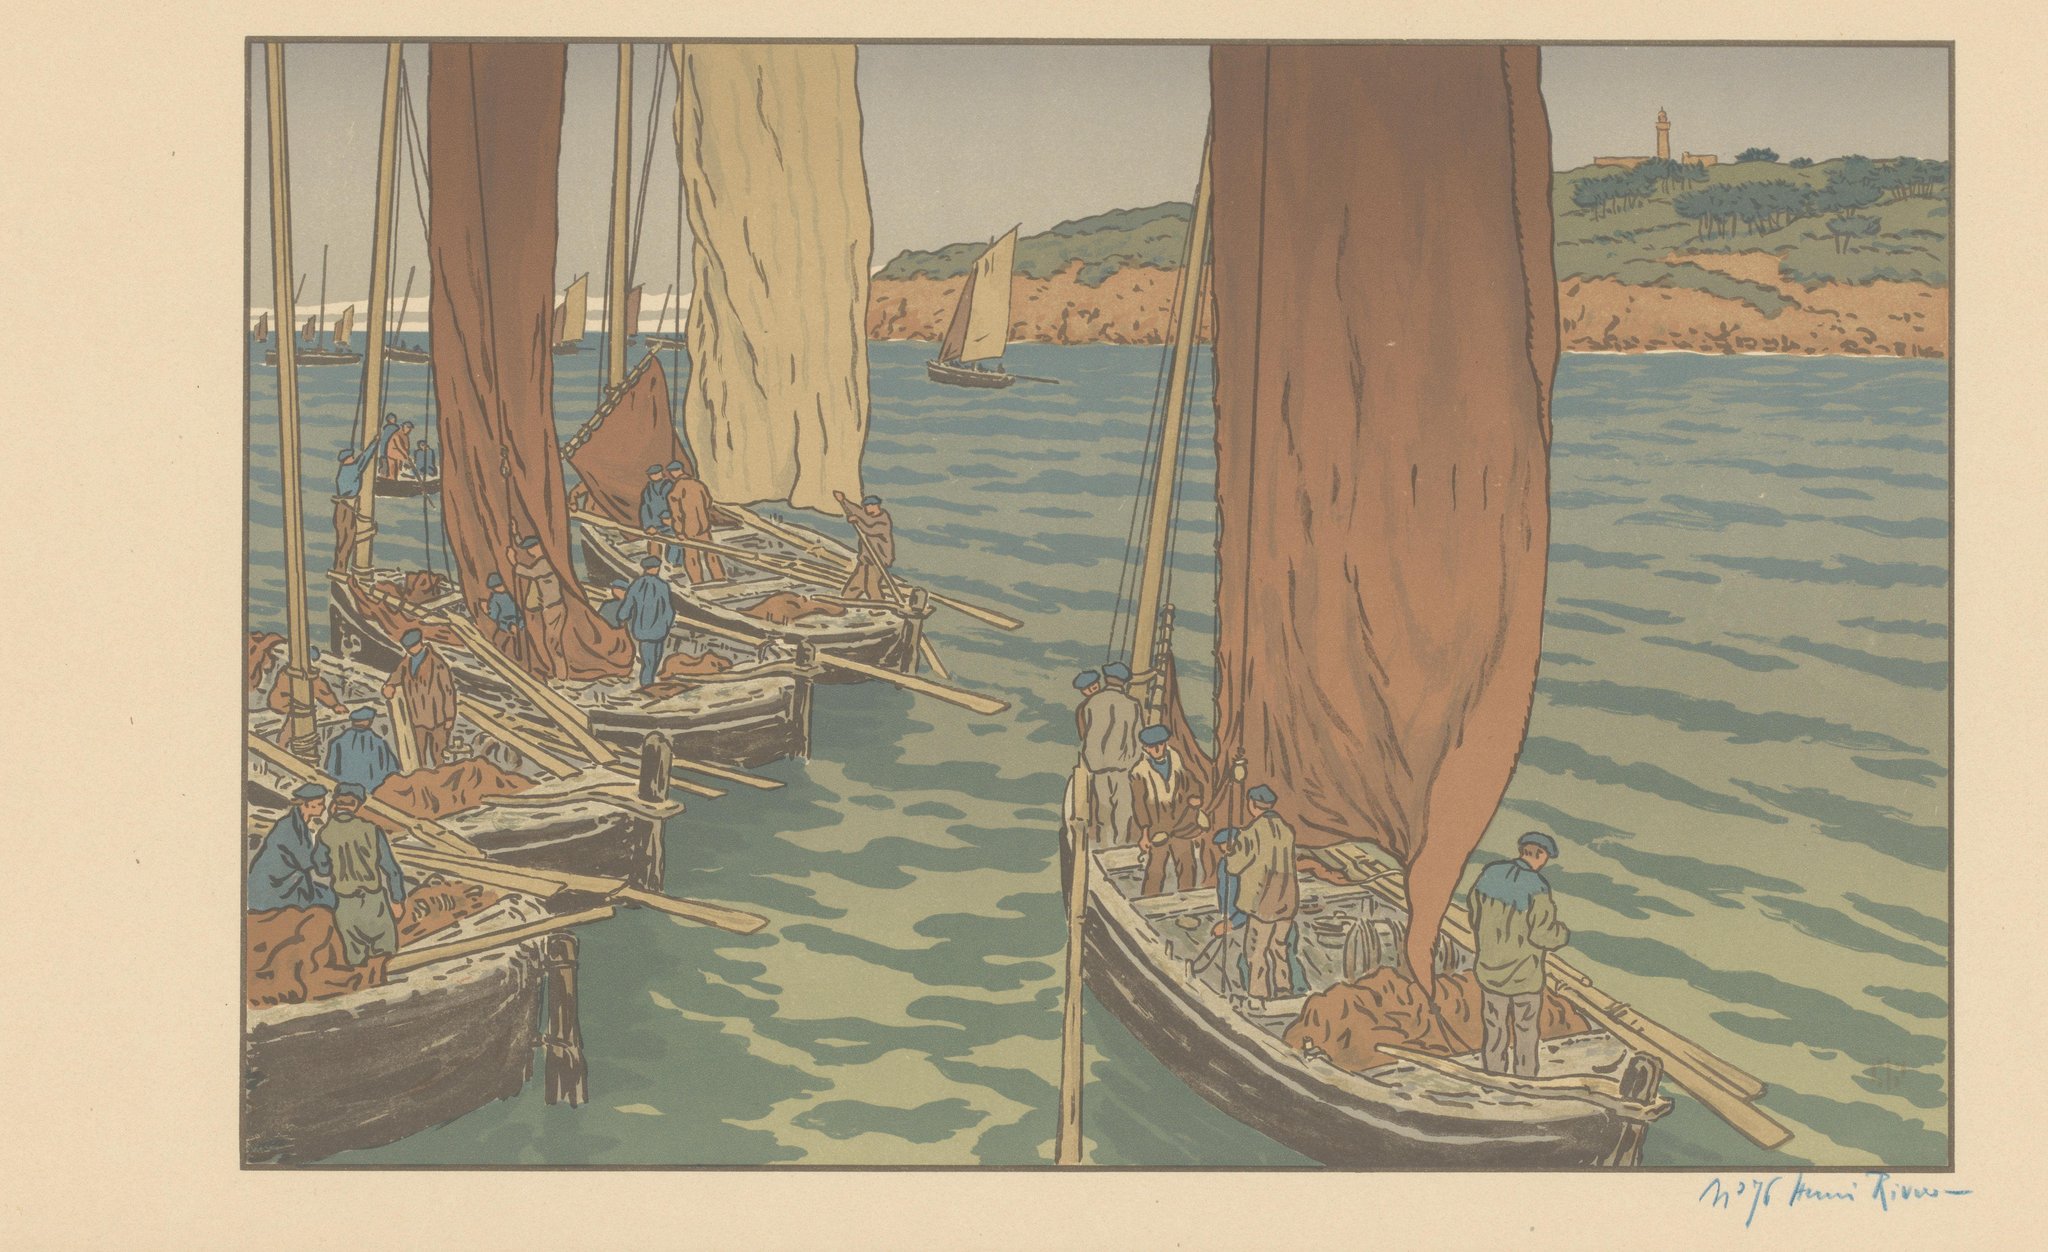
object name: print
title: Vissersschepen varen uit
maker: henri rivière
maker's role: draughtsman, print maker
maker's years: 1864-1951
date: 1874-1951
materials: paper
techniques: lithograph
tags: sea and coastal fishery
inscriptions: inscription: ‘No 76 Henri Rivière’, collector's mark: Lugt 2228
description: Het stempel van Henri Rivières monogram is meegedrukt. Zie: Toudouze, Georges. Henri Rivière. Peintre et Imagier. Parijs: Henri Floury, 1907, p. 177. Deze prent is mogelijk de eerste van een prentserie van tien prenten met als serietitel: Le beau pays de Bretagne. Prenttitel: Départ de bateaux à Tréboul (1898). Zie: Toudouze, Georges. Henri Rivière. Peintre et Imagier. Parijs: Henri Floury, 1907, p. 164.